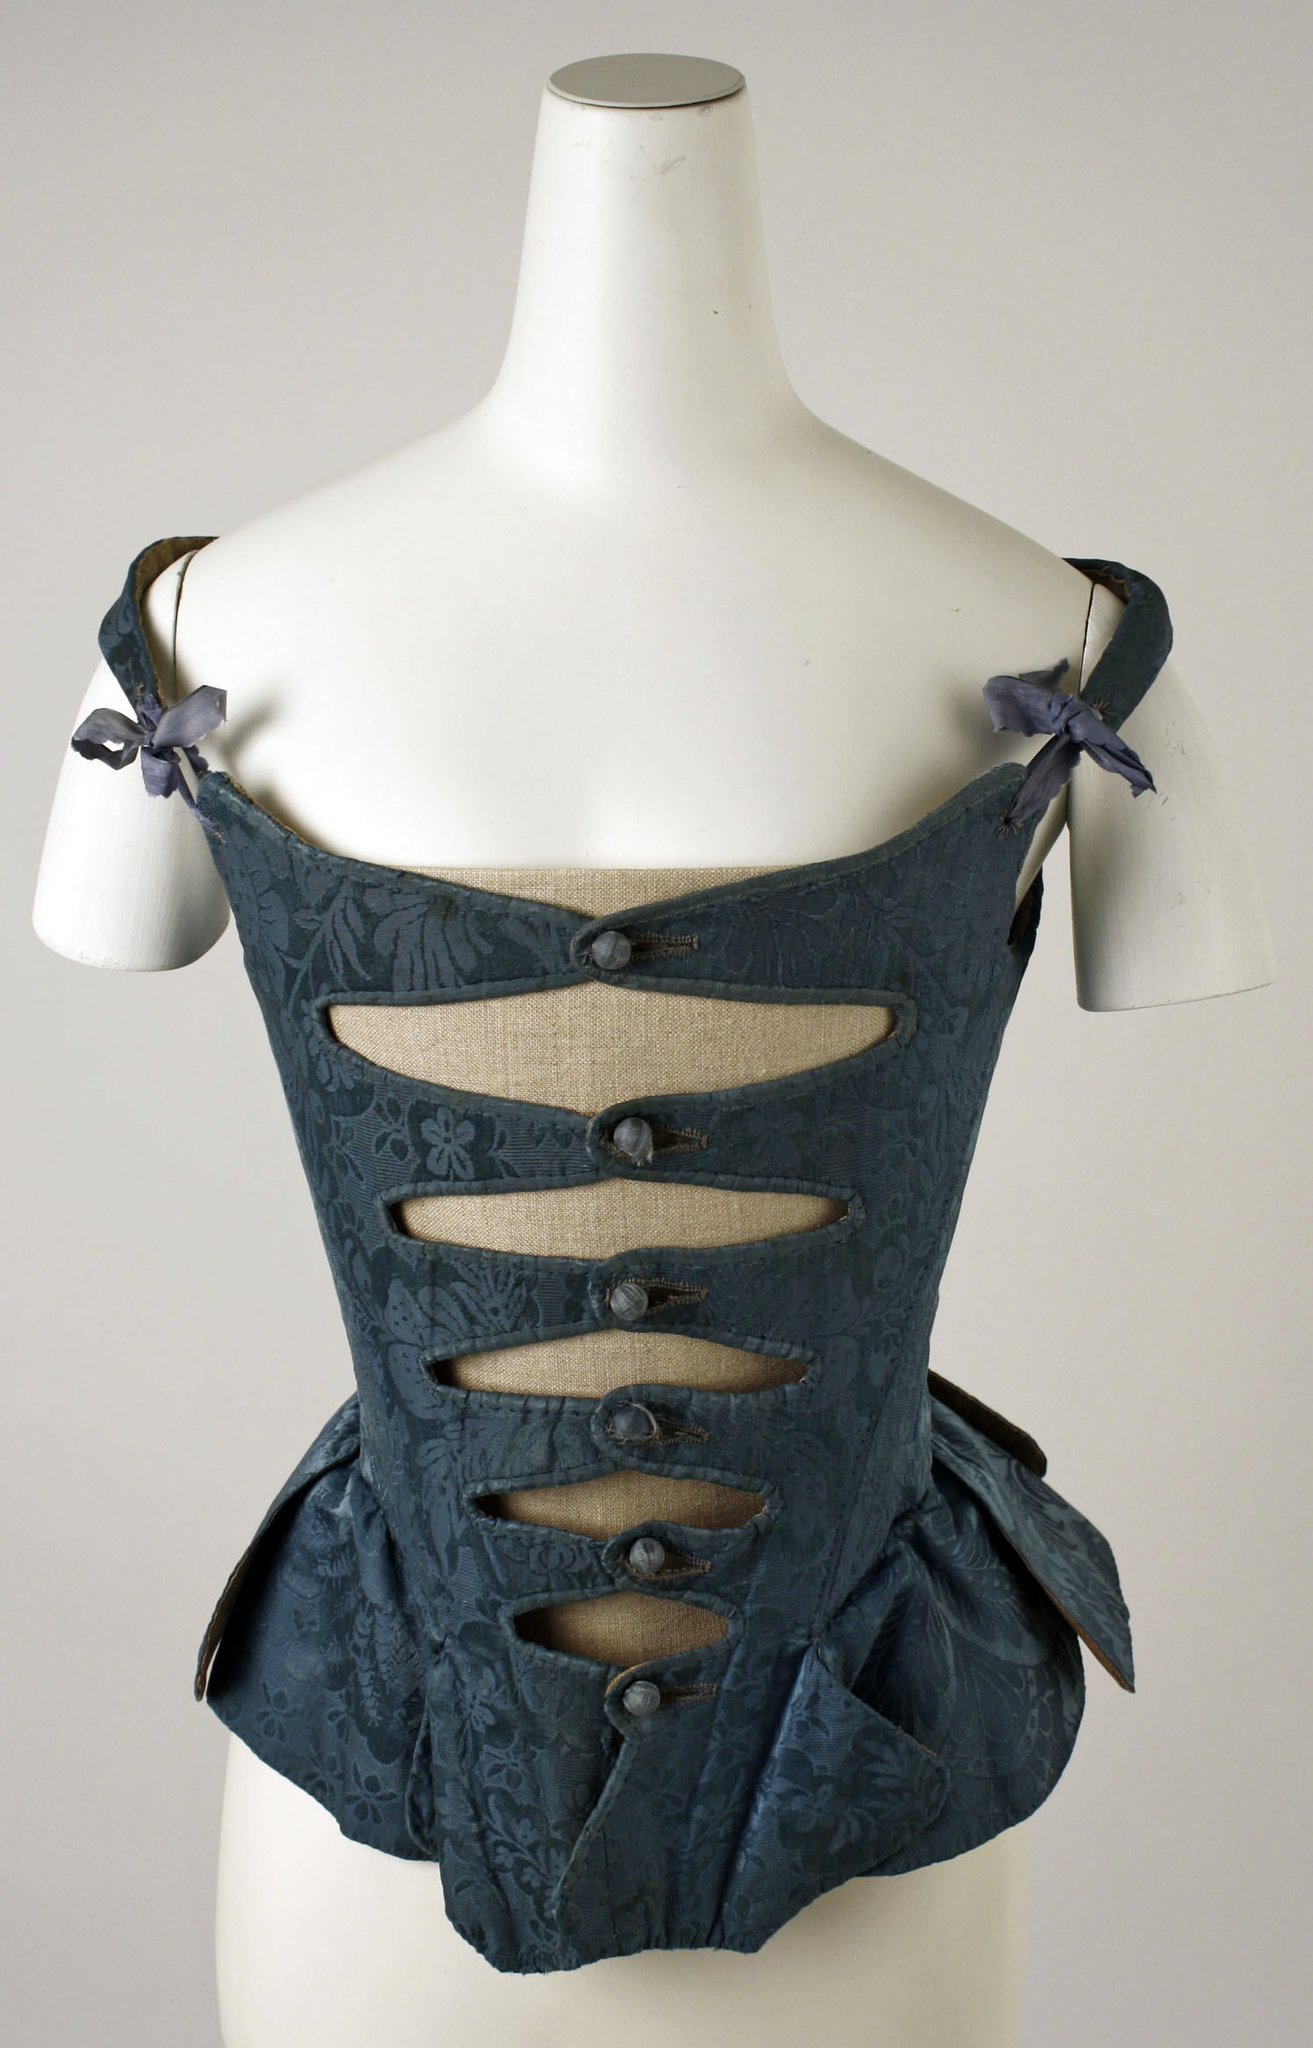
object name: corset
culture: european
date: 1767-1800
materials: cotton, leather, silk